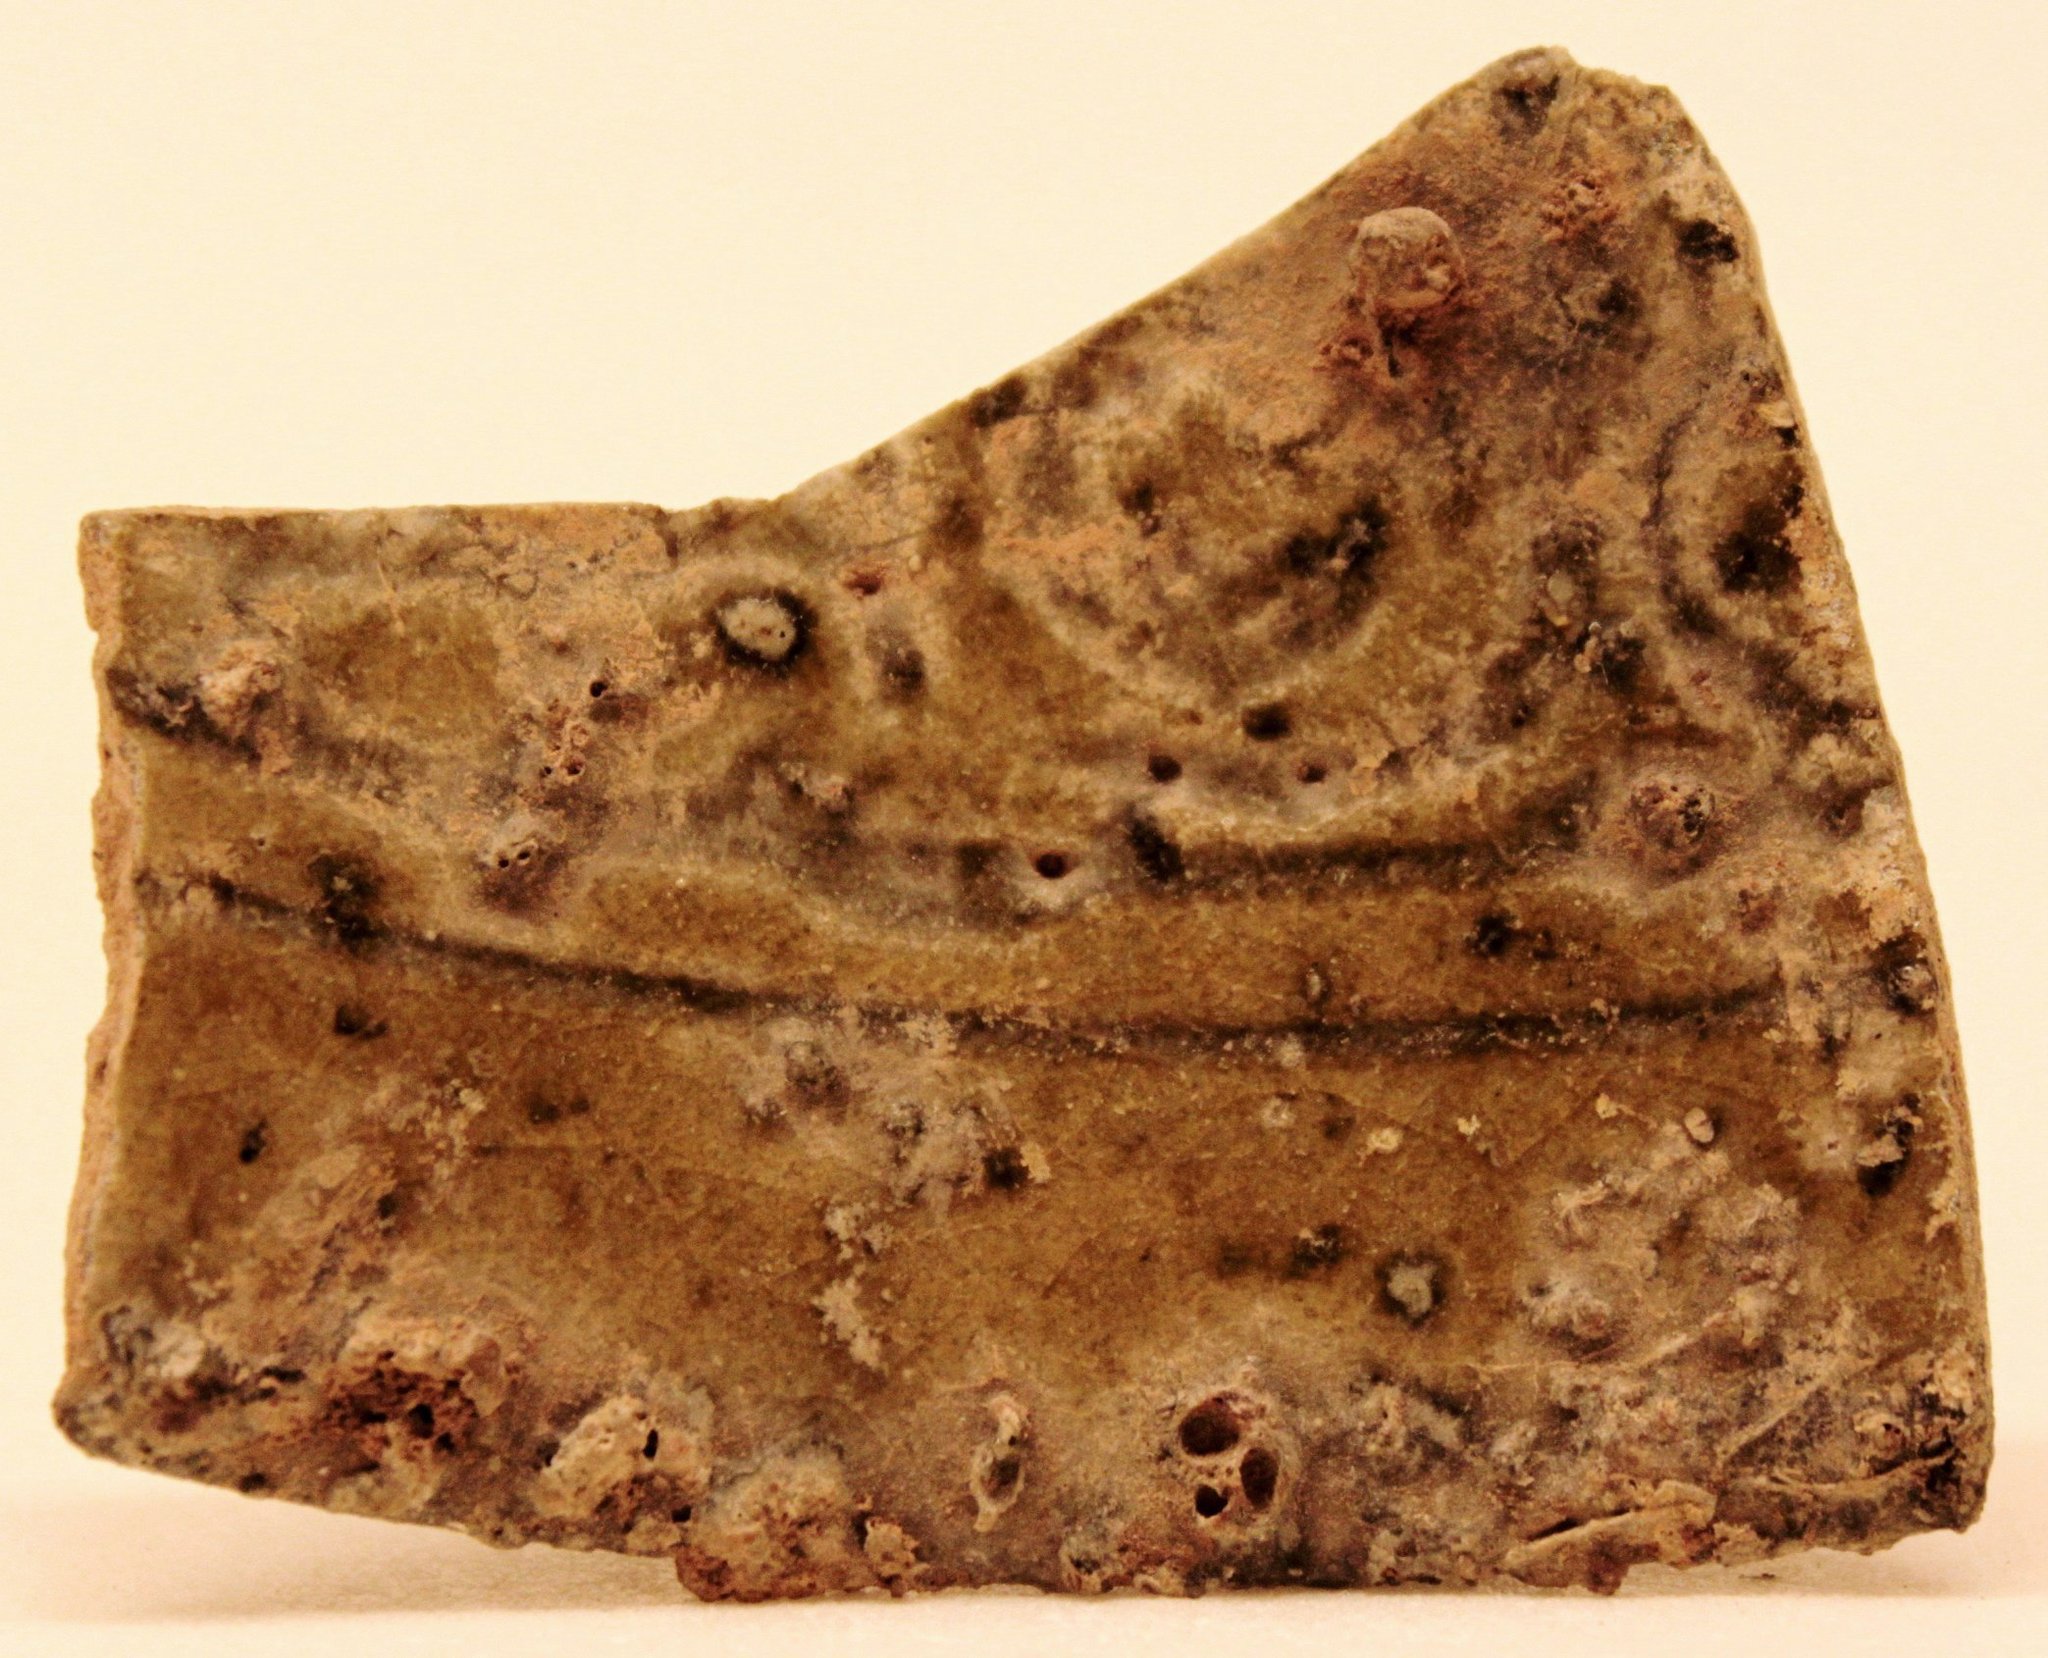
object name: fragment of a waster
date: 1001-1200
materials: ceramic glaze, glaze, stonepaste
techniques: incising, molding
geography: iran